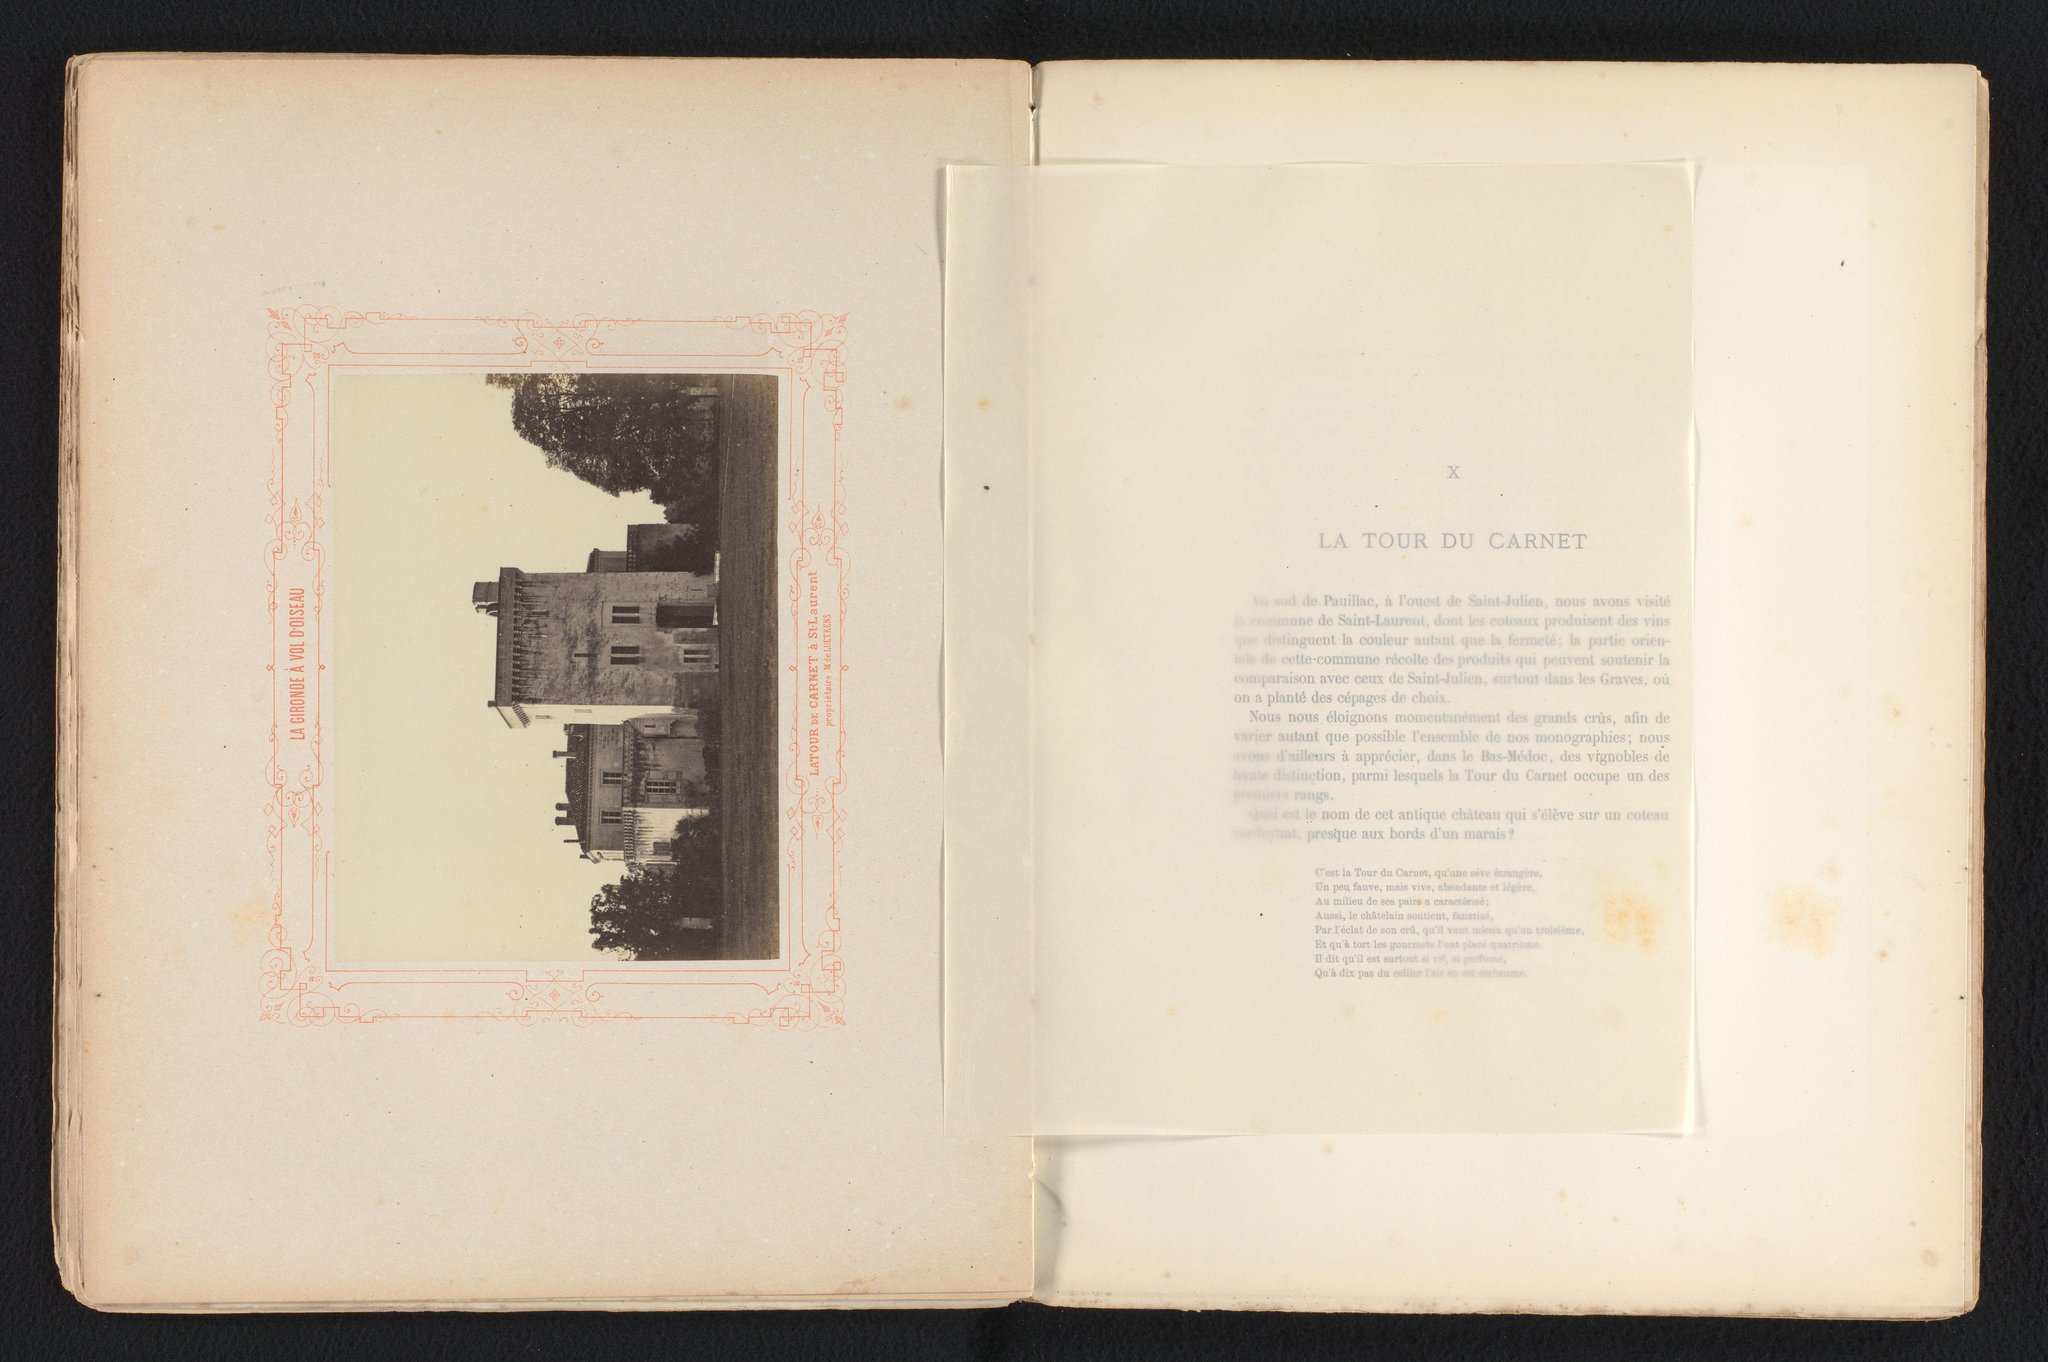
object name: photograph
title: Gezicht op Château La Tour Carnet in Saint-Laurent, Frankrijk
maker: alfred danflou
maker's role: fotograaf, schrijver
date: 1862-1867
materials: paper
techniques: albumen print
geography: saint-laurent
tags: castle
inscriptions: inscription: ‘propriétaire: M. de LUETKENS.’